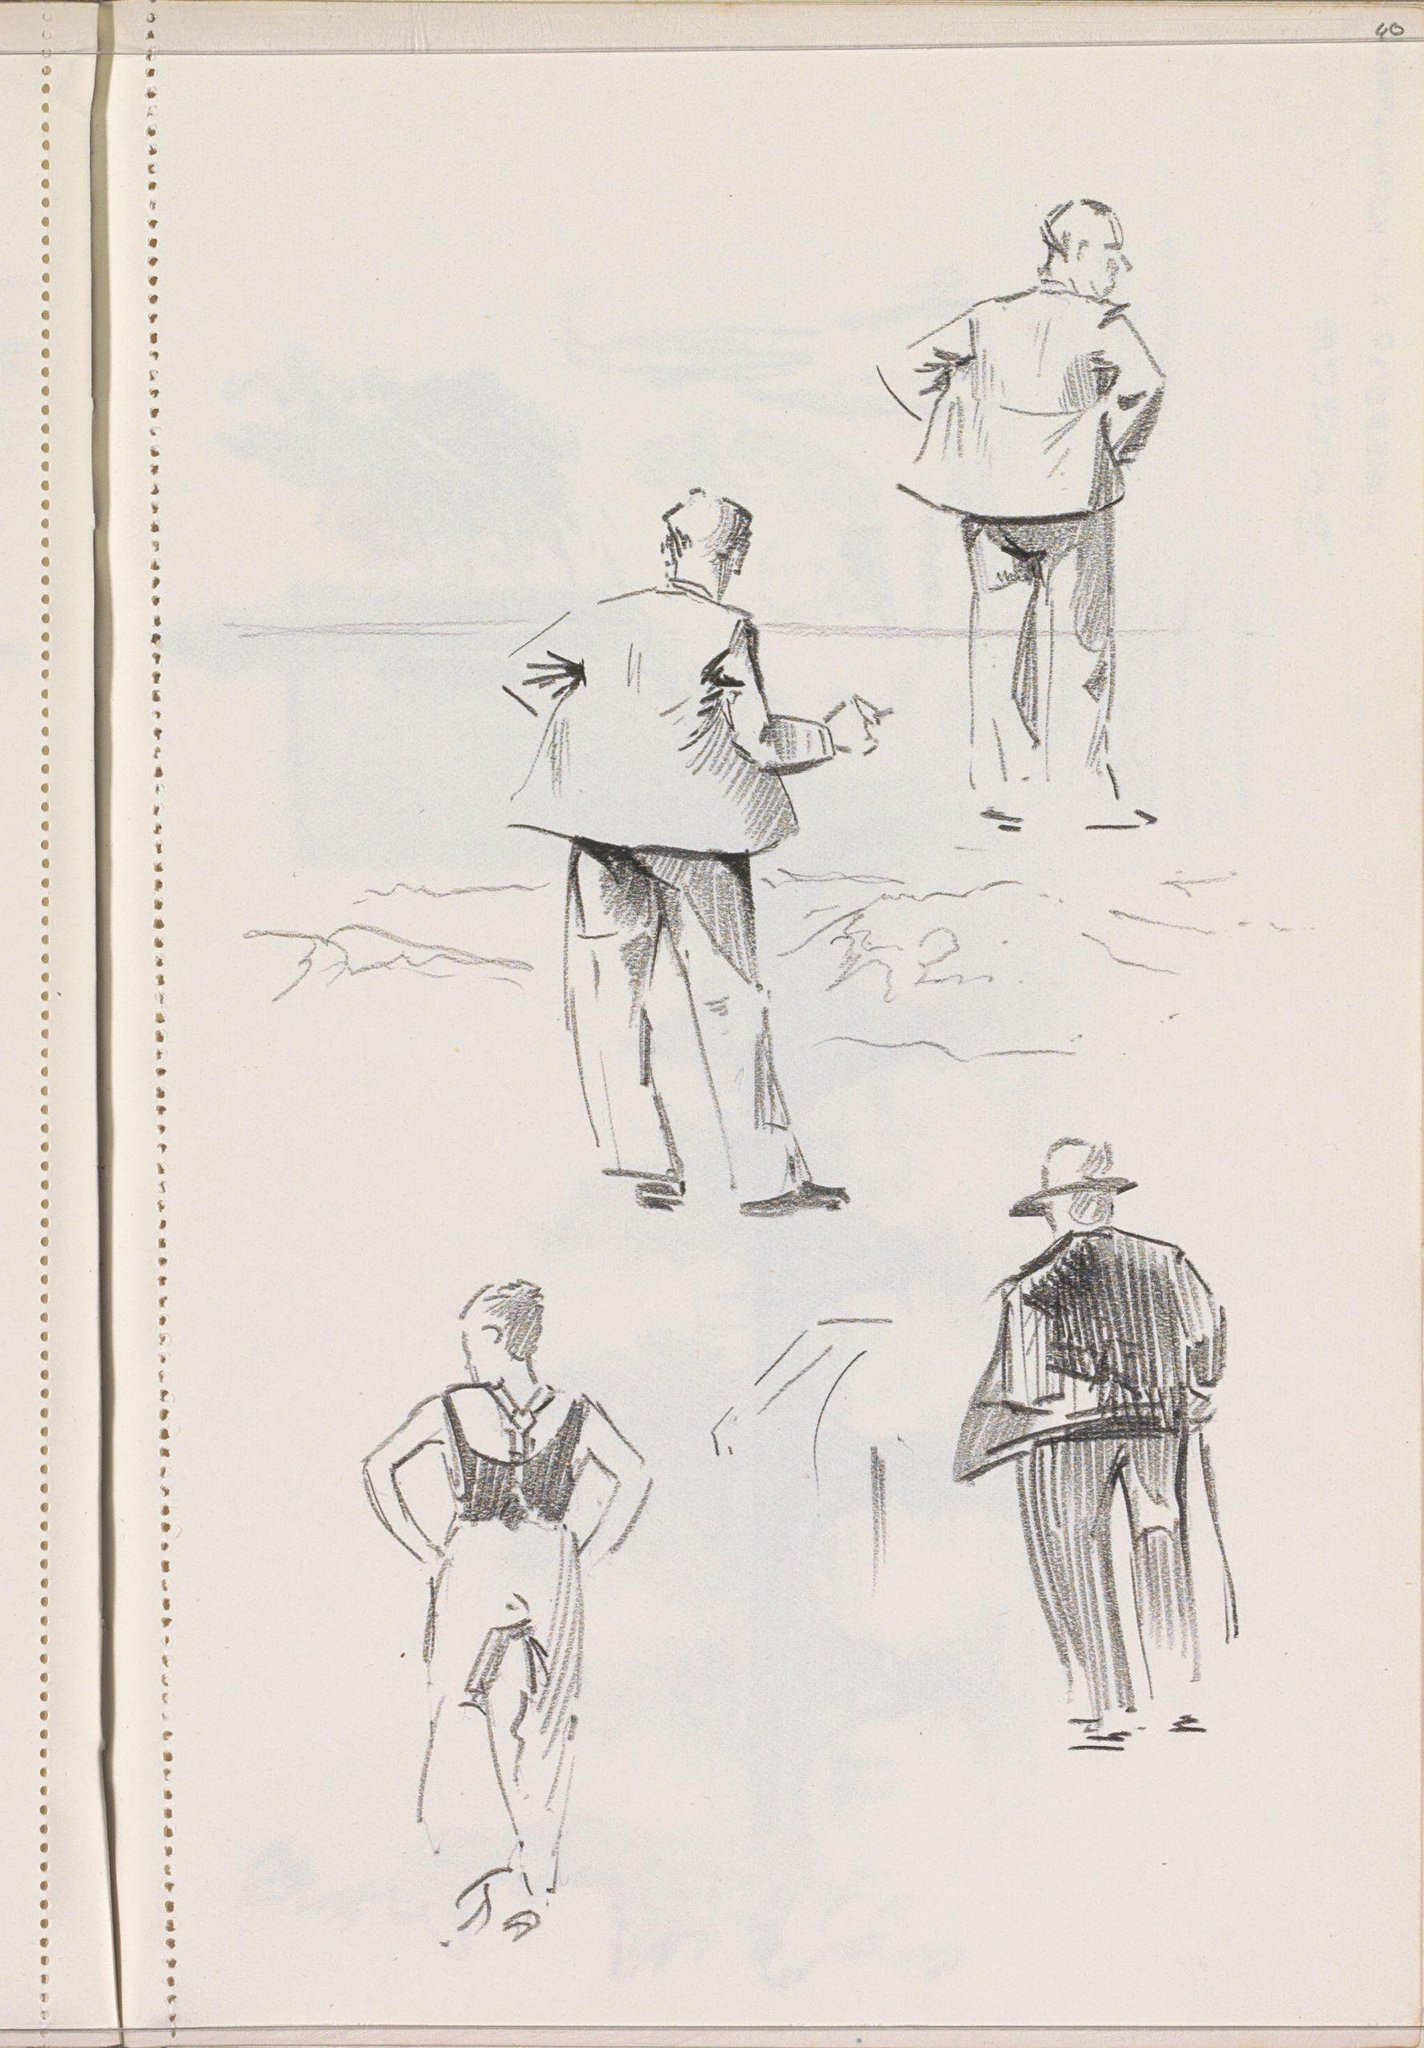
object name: sketchbook leaf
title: Staande mannen, mogelijk op een strand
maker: otto verhagen (i)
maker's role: draughtsman, print maker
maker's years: 1885-1951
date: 1930-1940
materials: chalk, paper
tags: standing figure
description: Pagina 40 uit een schetsboek met 60 bladen.